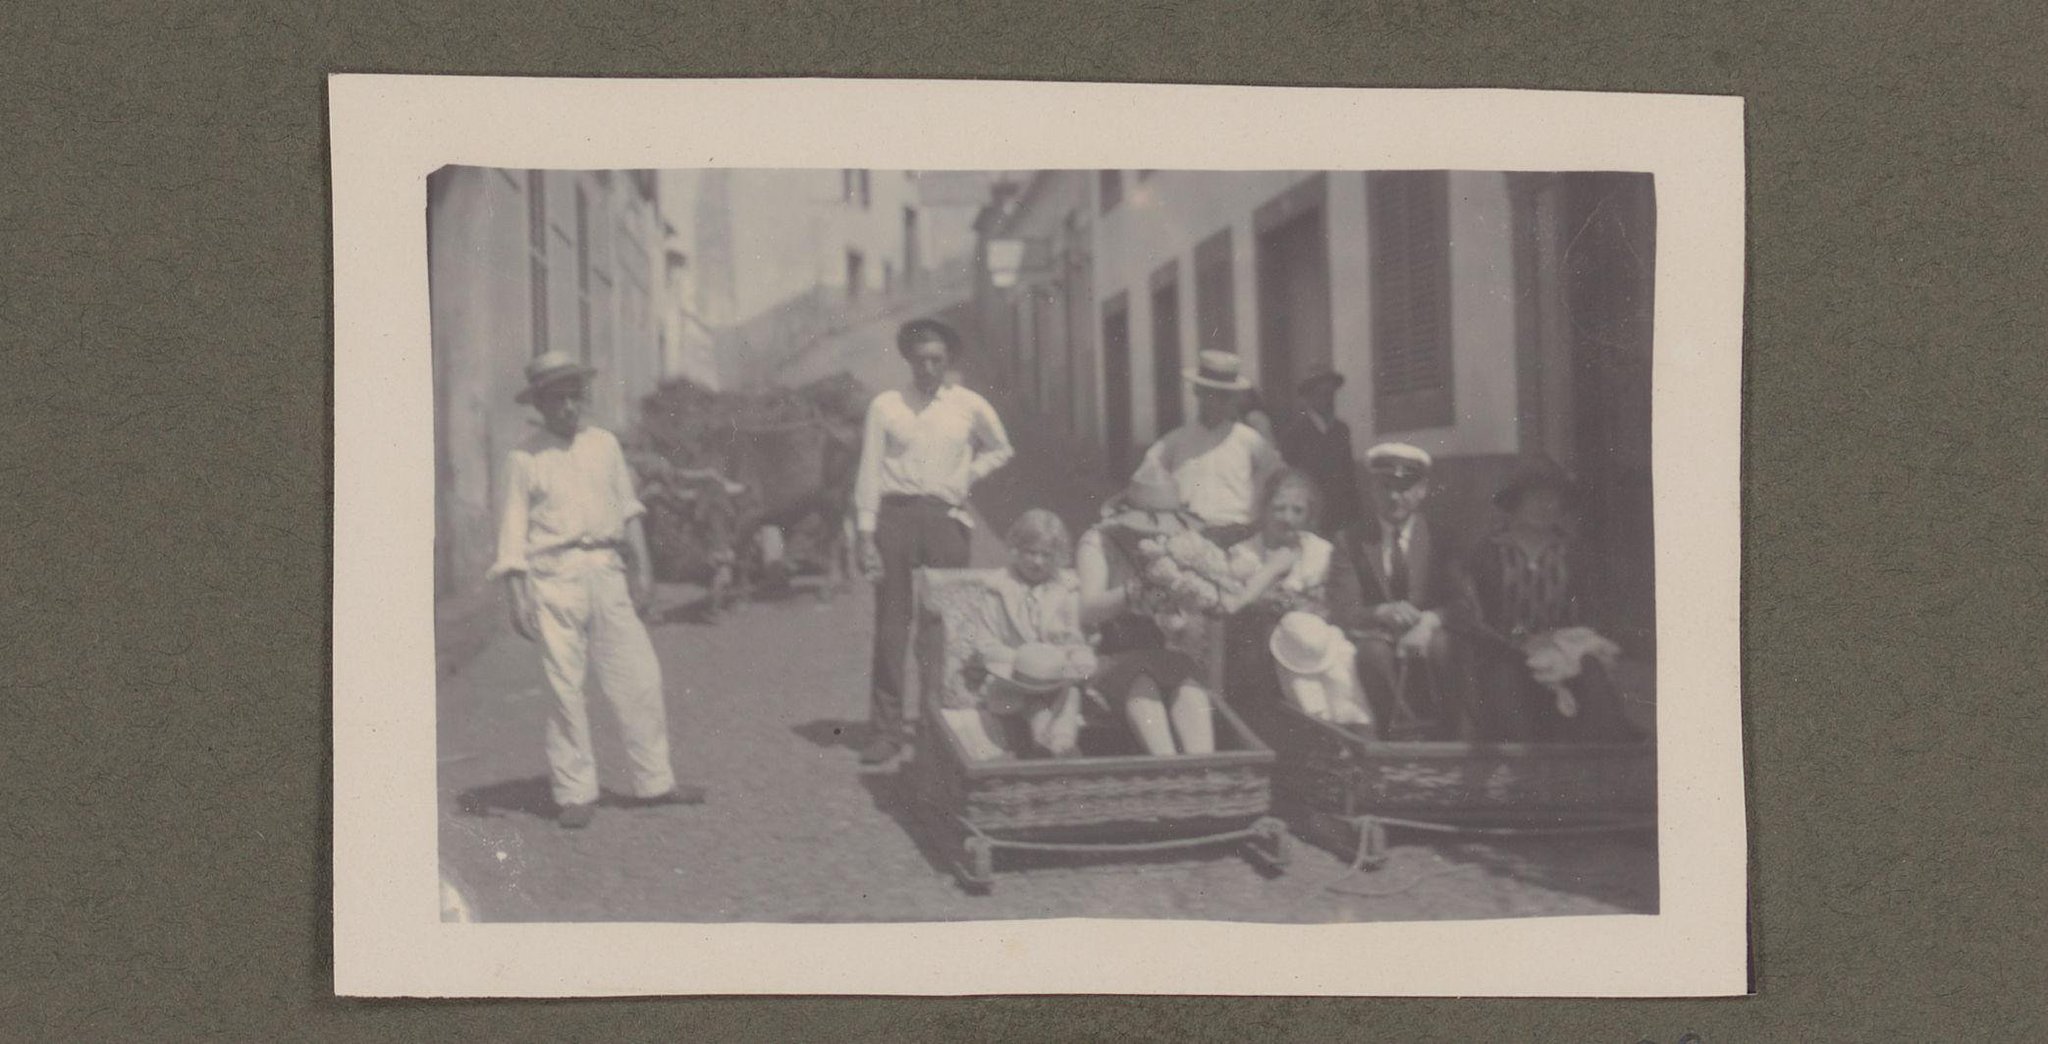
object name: photograph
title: Straatgezicht te Madeira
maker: Anonymous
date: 1925-1927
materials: photographic support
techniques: photography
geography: suriname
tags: jetten, familie, moengo, madeira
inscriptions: inscription: ‘Madeira’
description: Straatgezicht tijdens bezoek aan Madeira. Foto op een bladzijde van een los albumblad. Onderdeel van het ensemble met foto's van de familie van ingenieur Jetten in de mijnbouwstad Moengo in Suriname.